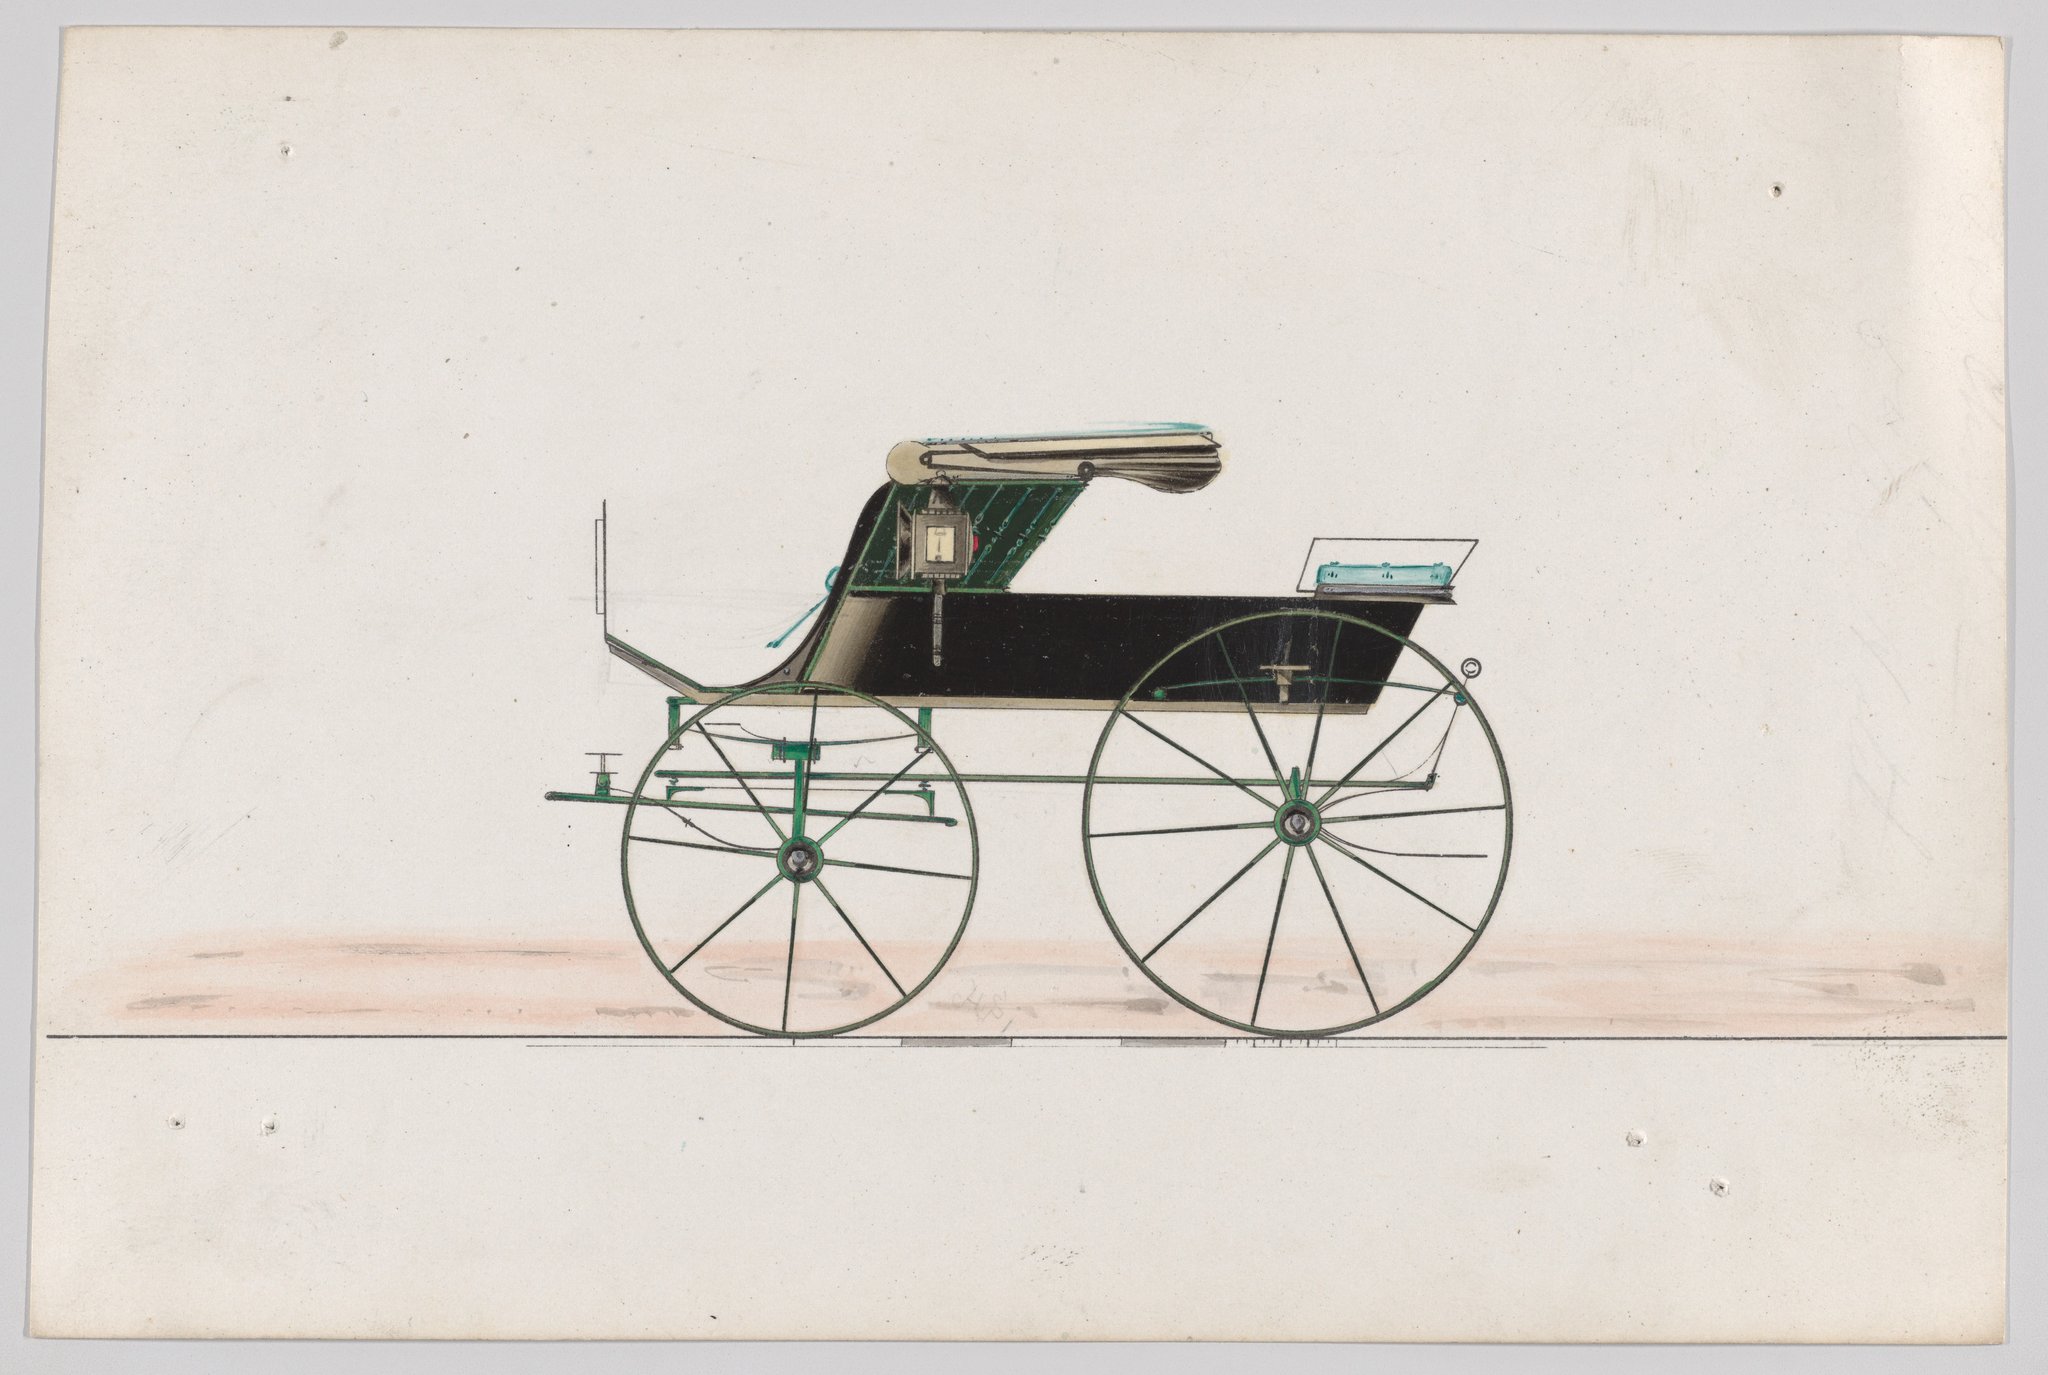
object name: drawing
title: Design for Stanhope Phaeton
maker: brewster & co.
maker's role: manufacturer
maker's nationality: american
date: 1850-1870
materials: gouache, gum arabic, ink, watercolor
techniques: pen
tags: carriages